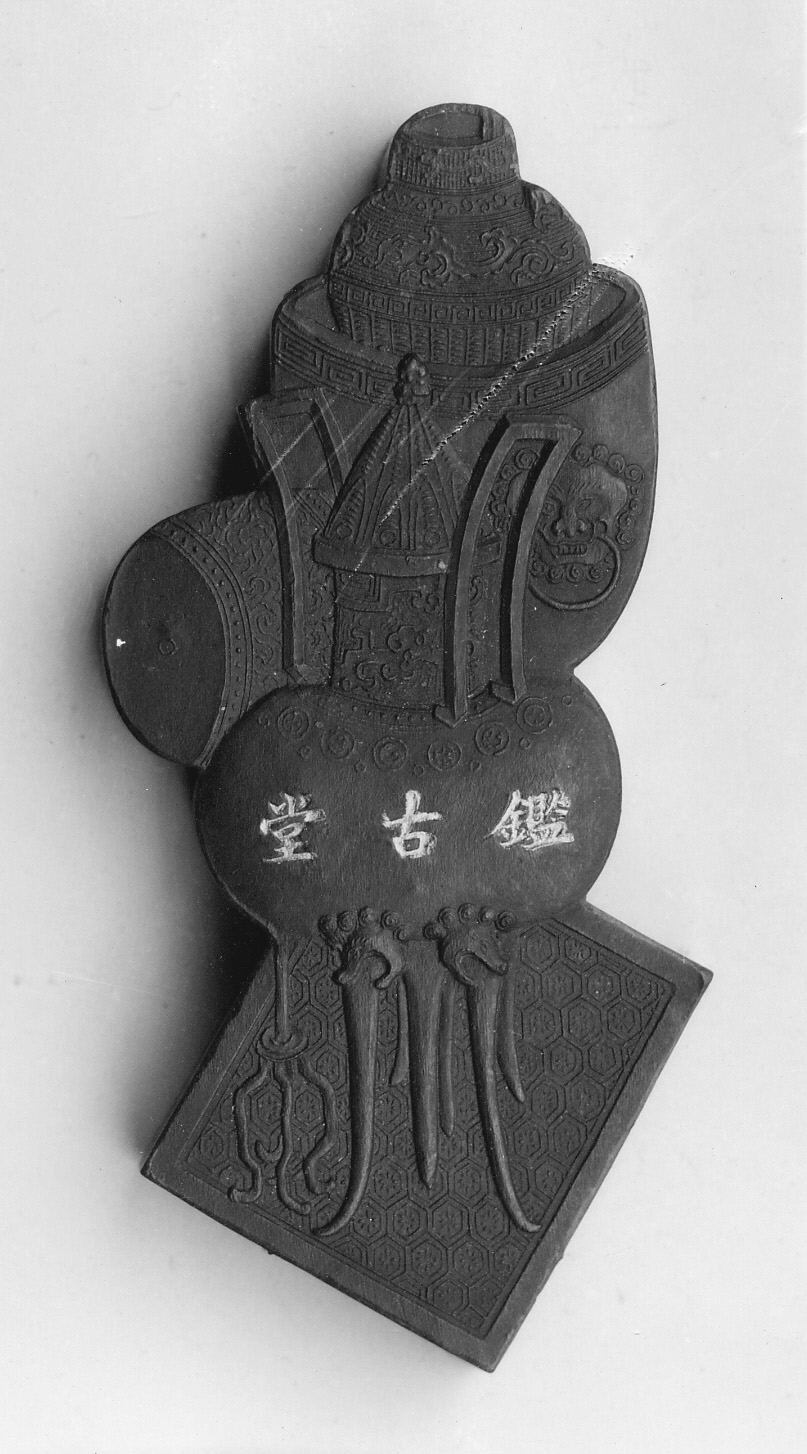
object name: ink tablet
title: The Mirroring of Antiquity Hall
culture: chinese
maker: jian guzhai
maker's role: artist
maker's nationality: chinese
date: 1867-1933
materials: gilt, wood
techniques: bookbinding